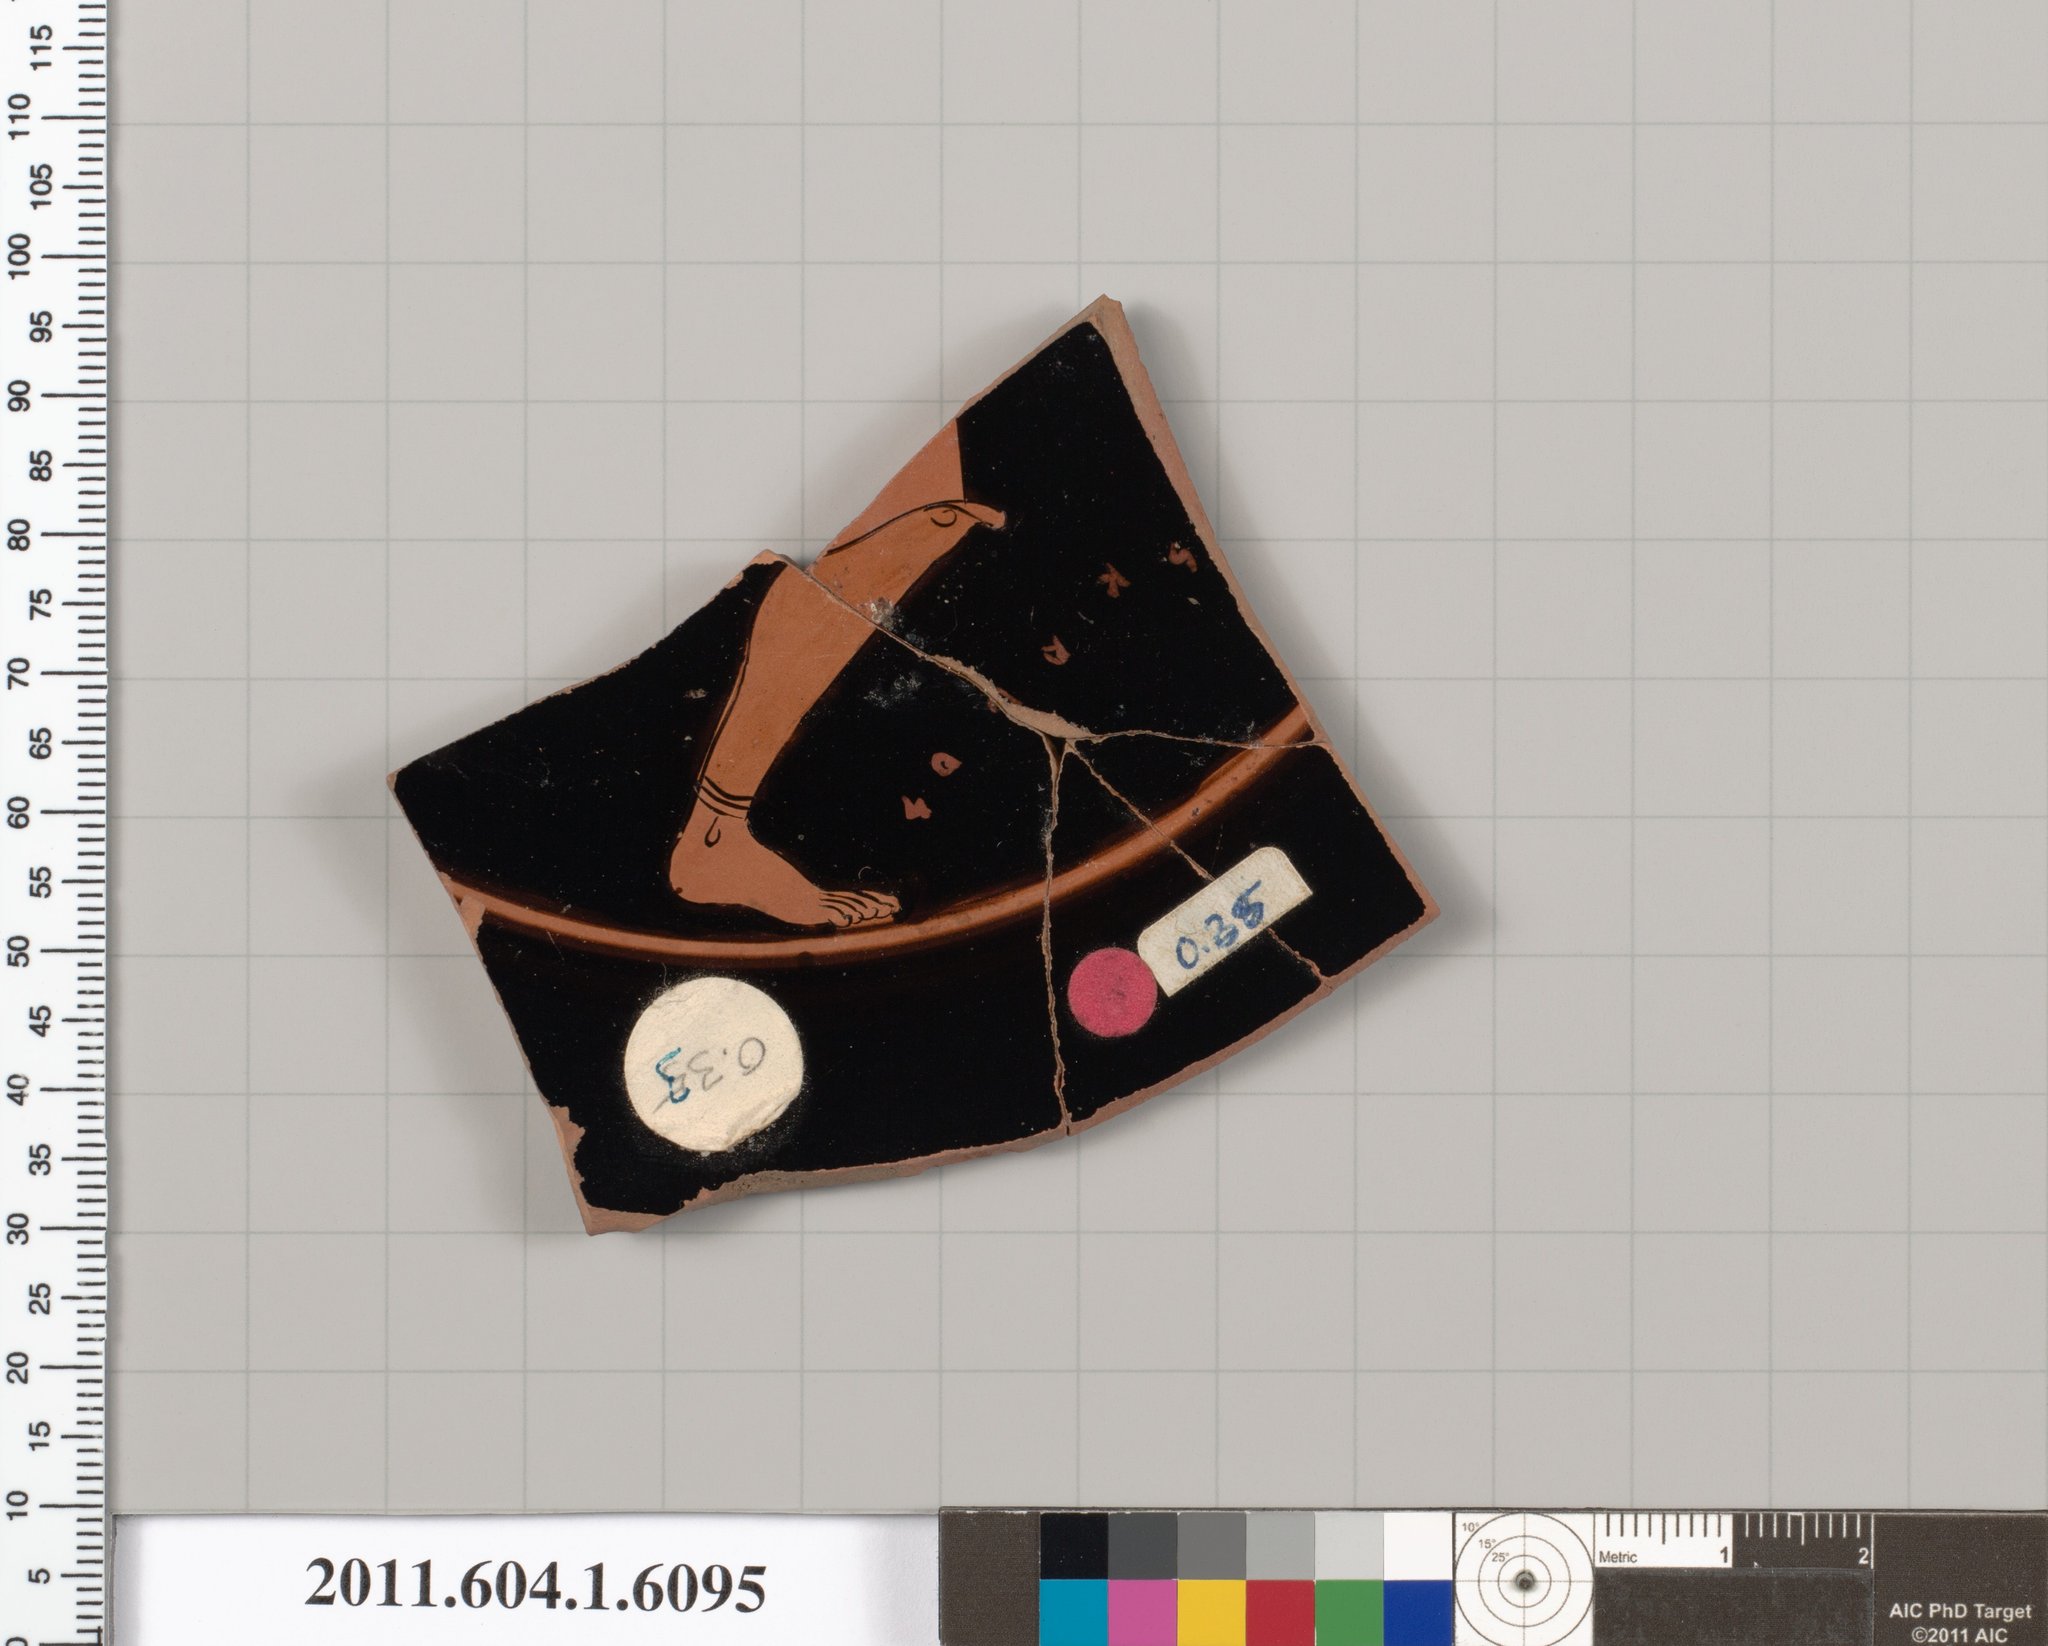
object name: kylix fragment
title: Terracotta fragment of a kylix (drinking cup)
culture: greek, attic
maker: apollodoros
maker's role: artist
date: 500-490 BCE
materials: terracotta